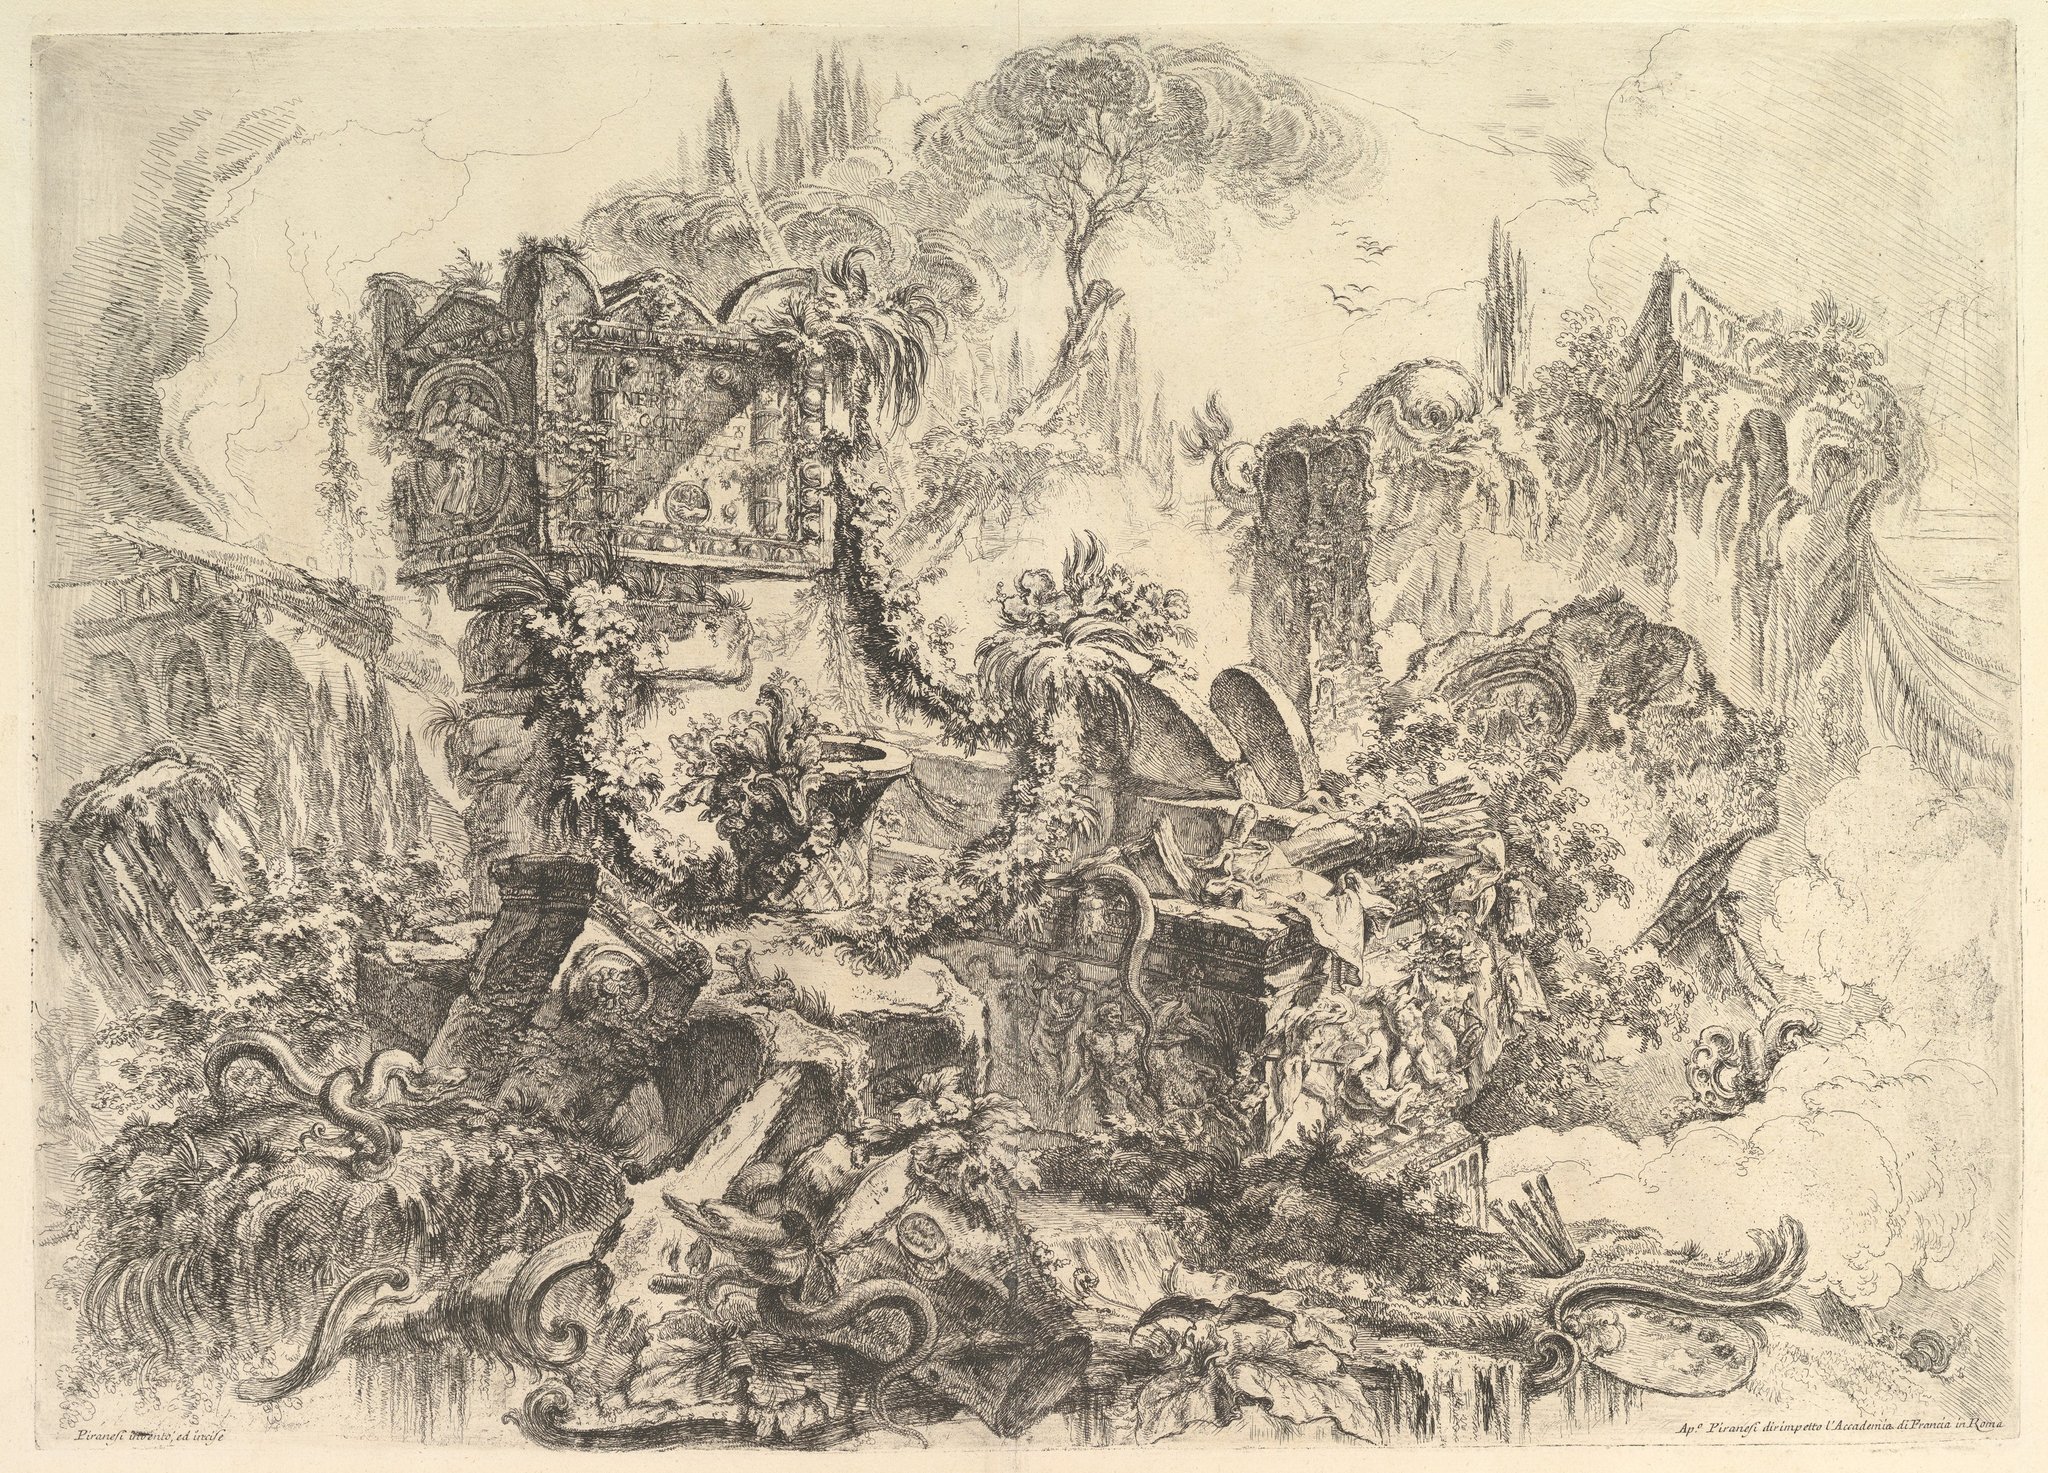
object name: print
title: The Tomb of Nero, from "Grotteschi" (Grotesques)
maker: giovanni battista piranesi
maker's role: artist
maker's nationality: italian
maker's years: 1720-1778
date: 1748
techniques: drypoint, engraving, etching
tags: tombs,trees